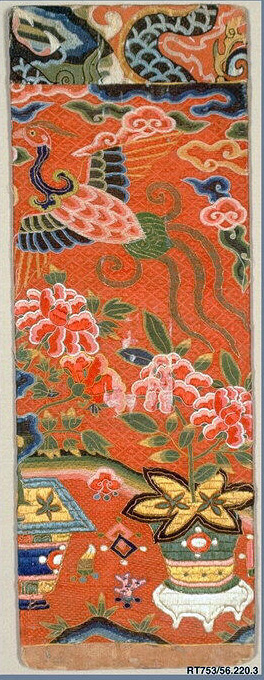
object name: book or sutra cover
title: Sutra or Book Cover with Phoenix and Potted Plants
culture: chinese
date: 1501-1600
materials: textile, metal thread, silk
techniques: embroidery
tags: mythical creatures,flowers,plants